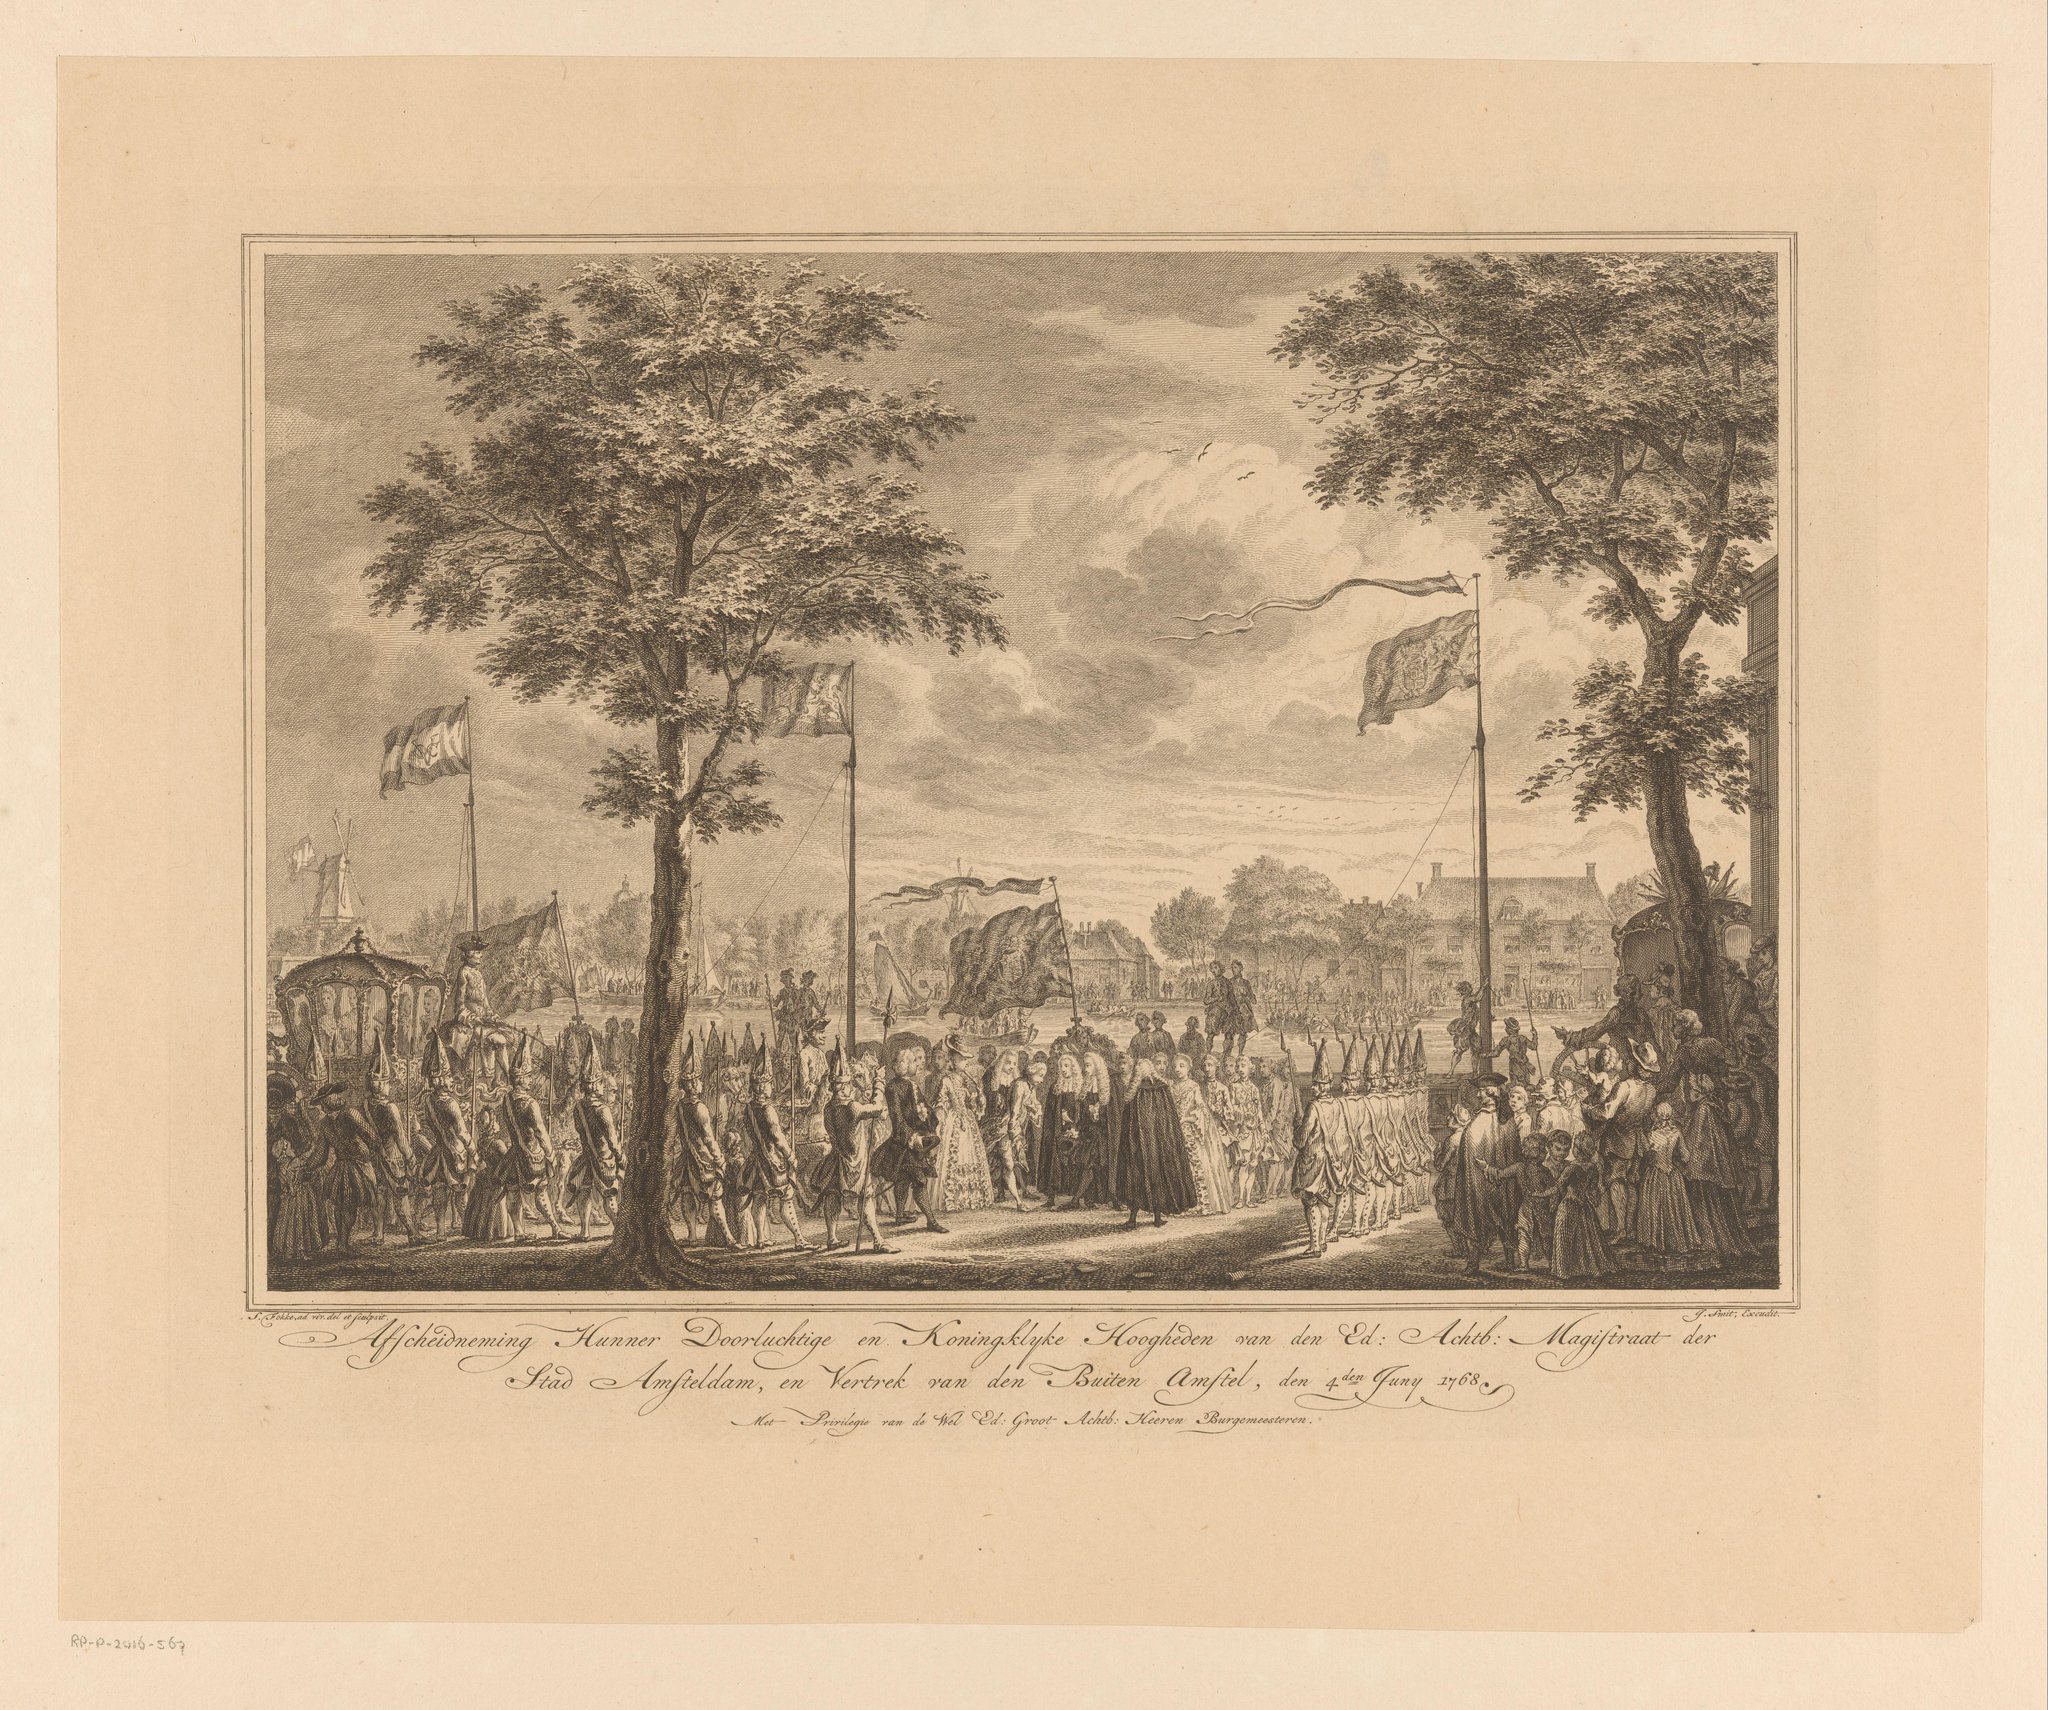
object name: print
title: Afscheidneming hunner doorluchtige en koningklyke hoogheden van den ed: achtb: magistraat der stad Amsteldam, en vertrek van den Buiten Amstel, den 4den juny 1768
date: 1772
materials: paper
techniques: engraving, etching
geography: amsterdam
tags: william v (prince of orange), berlin, painter, draughtsman, wilhelmina of prussia (princess of orange), public festivities on the occasion of royal events, amsterdam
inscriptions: collector's mark: Lugt 2228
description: Stadhouder Willem V en prinses Wilhelmina van Pruisen nemen afscheid van het magistraat van Amsterdam bij de herberg De Berebijt aan de Buitenamstel, 4 juni 1768.